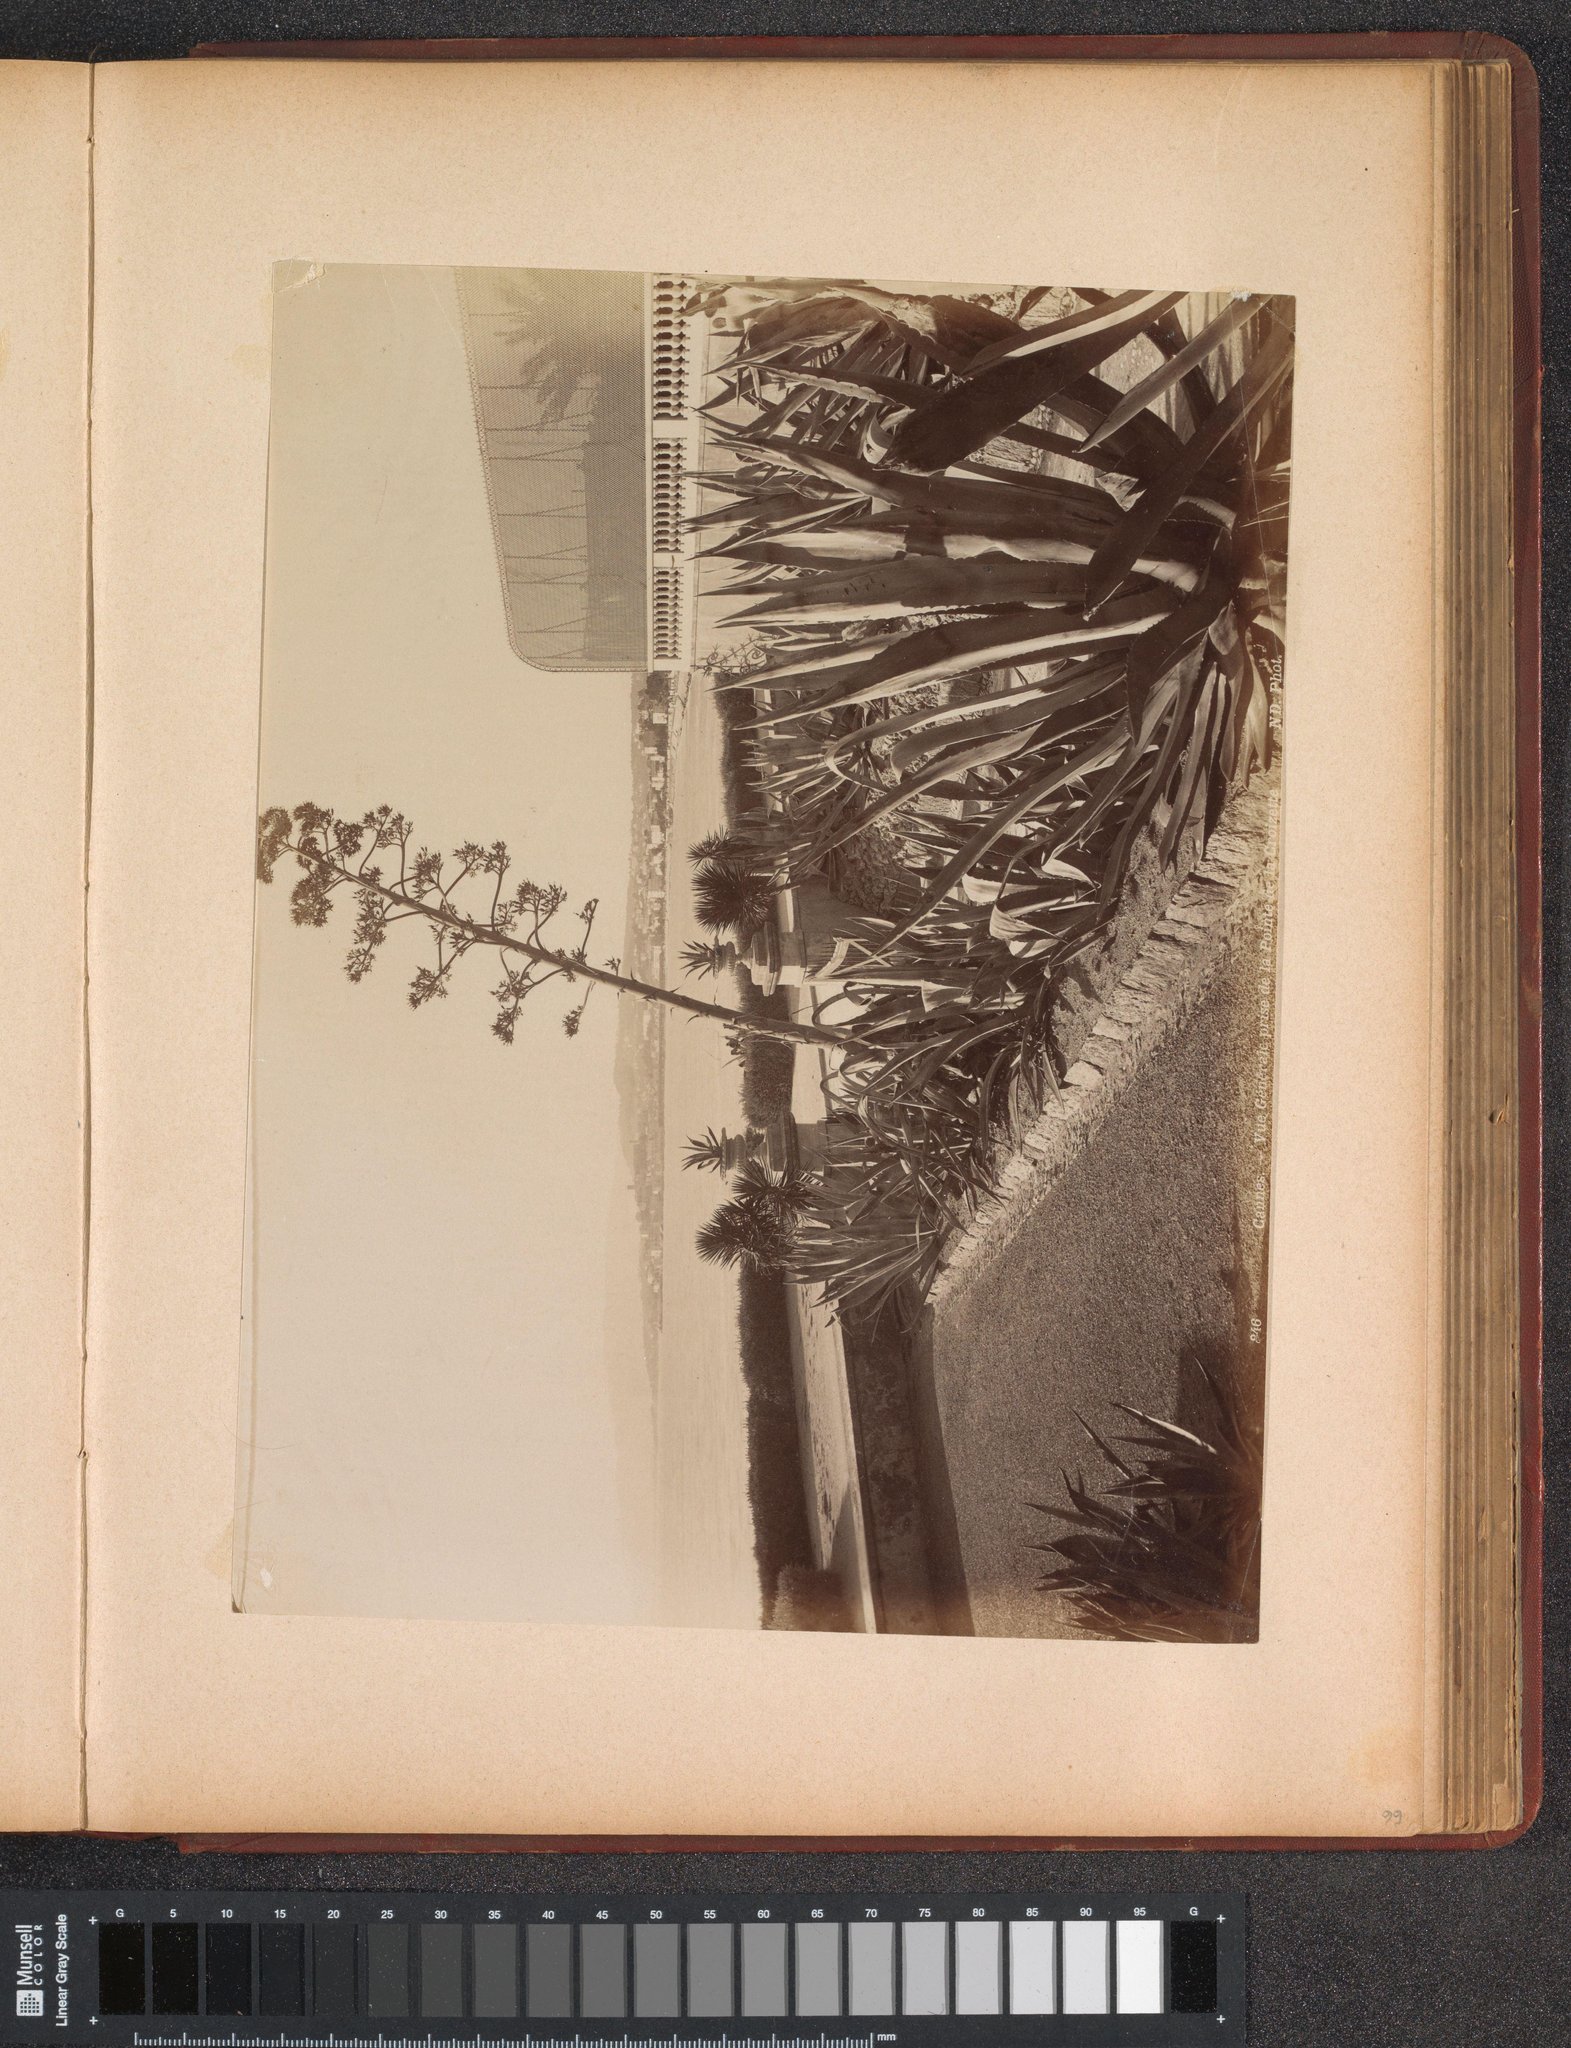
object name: photograph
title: Cannes. - Vue Générale prise de la Pointe de la Croizette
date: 1870-1900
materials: paper, photographic support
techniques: albumen print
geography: cannes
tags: gulf, bay (+ landscape with figures, staffage)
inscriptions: negative number: ‘846’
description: Onderdeel van Reisalbum met foto's van bezienswaardigheden in Italië en Zuid-Frankrijk.